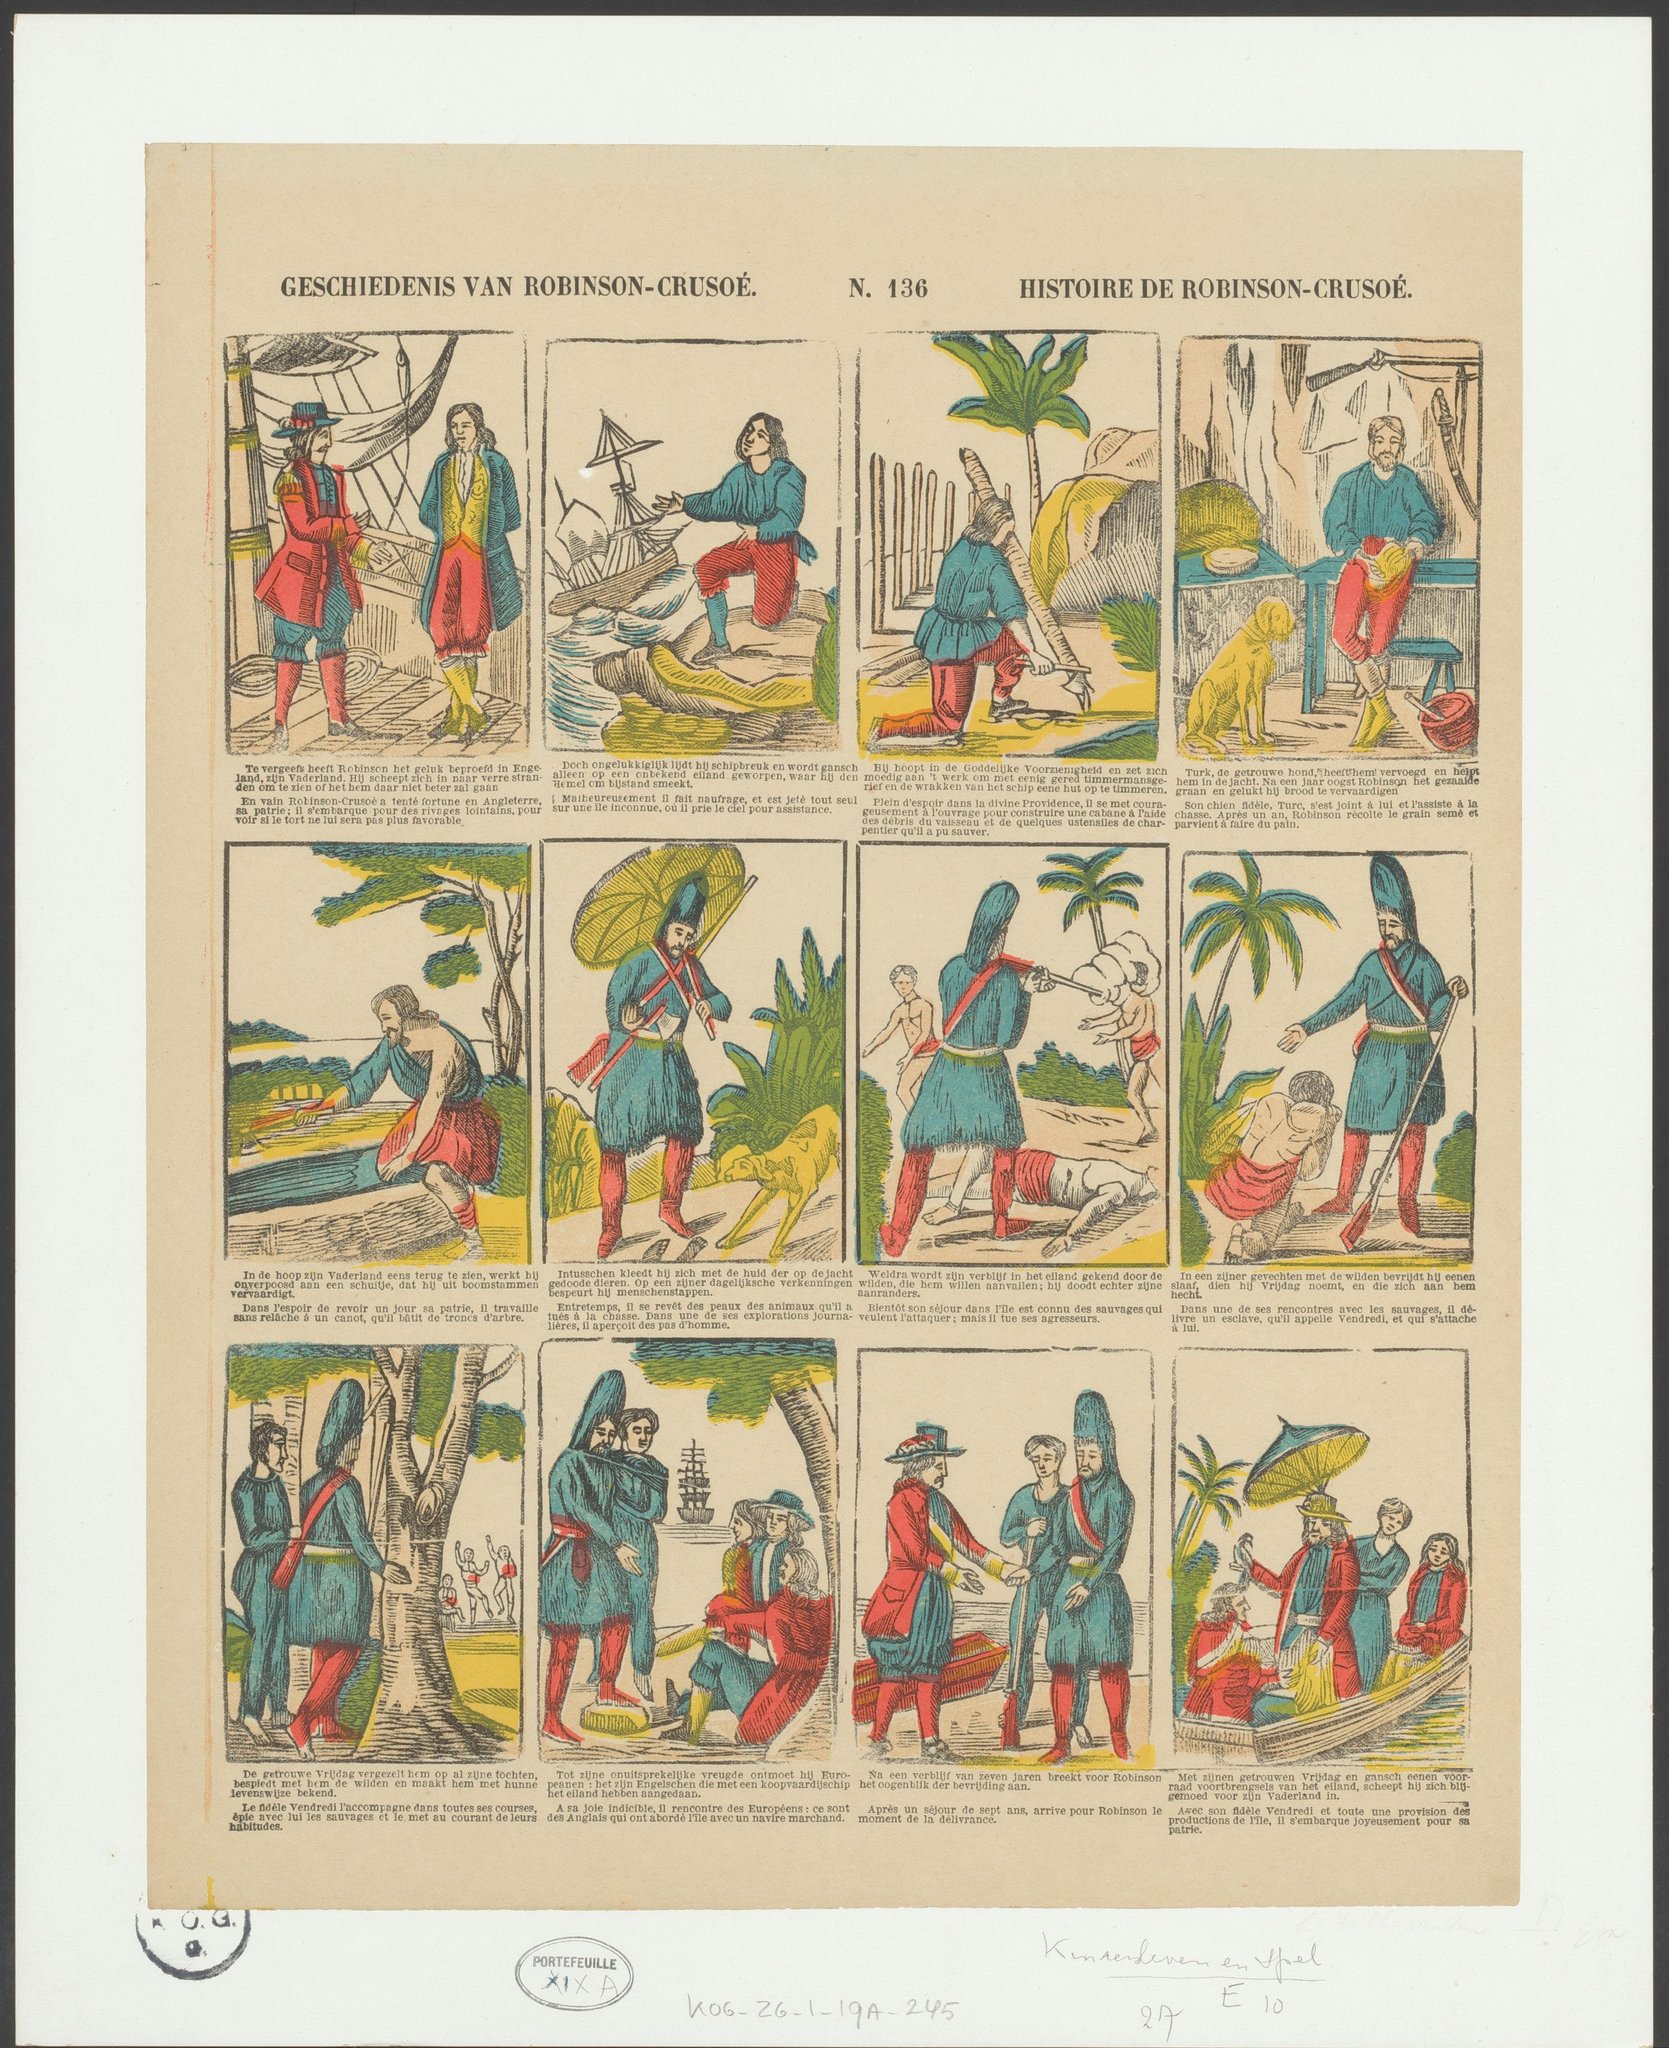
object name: print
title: Robinson Crusoe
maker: Anonymous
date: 1833-1911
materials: paper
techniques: lithograph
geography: turnhout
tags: (scenes from) specific works of literature: defoe, robinson crusoe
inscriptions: stamp, collector's mark: Lugt 1641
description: Blad met zestien voorstellingen uit het verhaal van Robinson Crusoe die strandt op een eiland. Onder elke afbeelding een onderschrift in het Nederlands en in het Frans. Genummerd midden boven: N. 136. Onderwerpsrubrieken binnen de Atlas Zeden en Gewoonten: Zeden en Gewoonten in Engeren Zin, Des menschen beging, midden en einde, Kinderleven – Kinderspel en Kinderprenten.